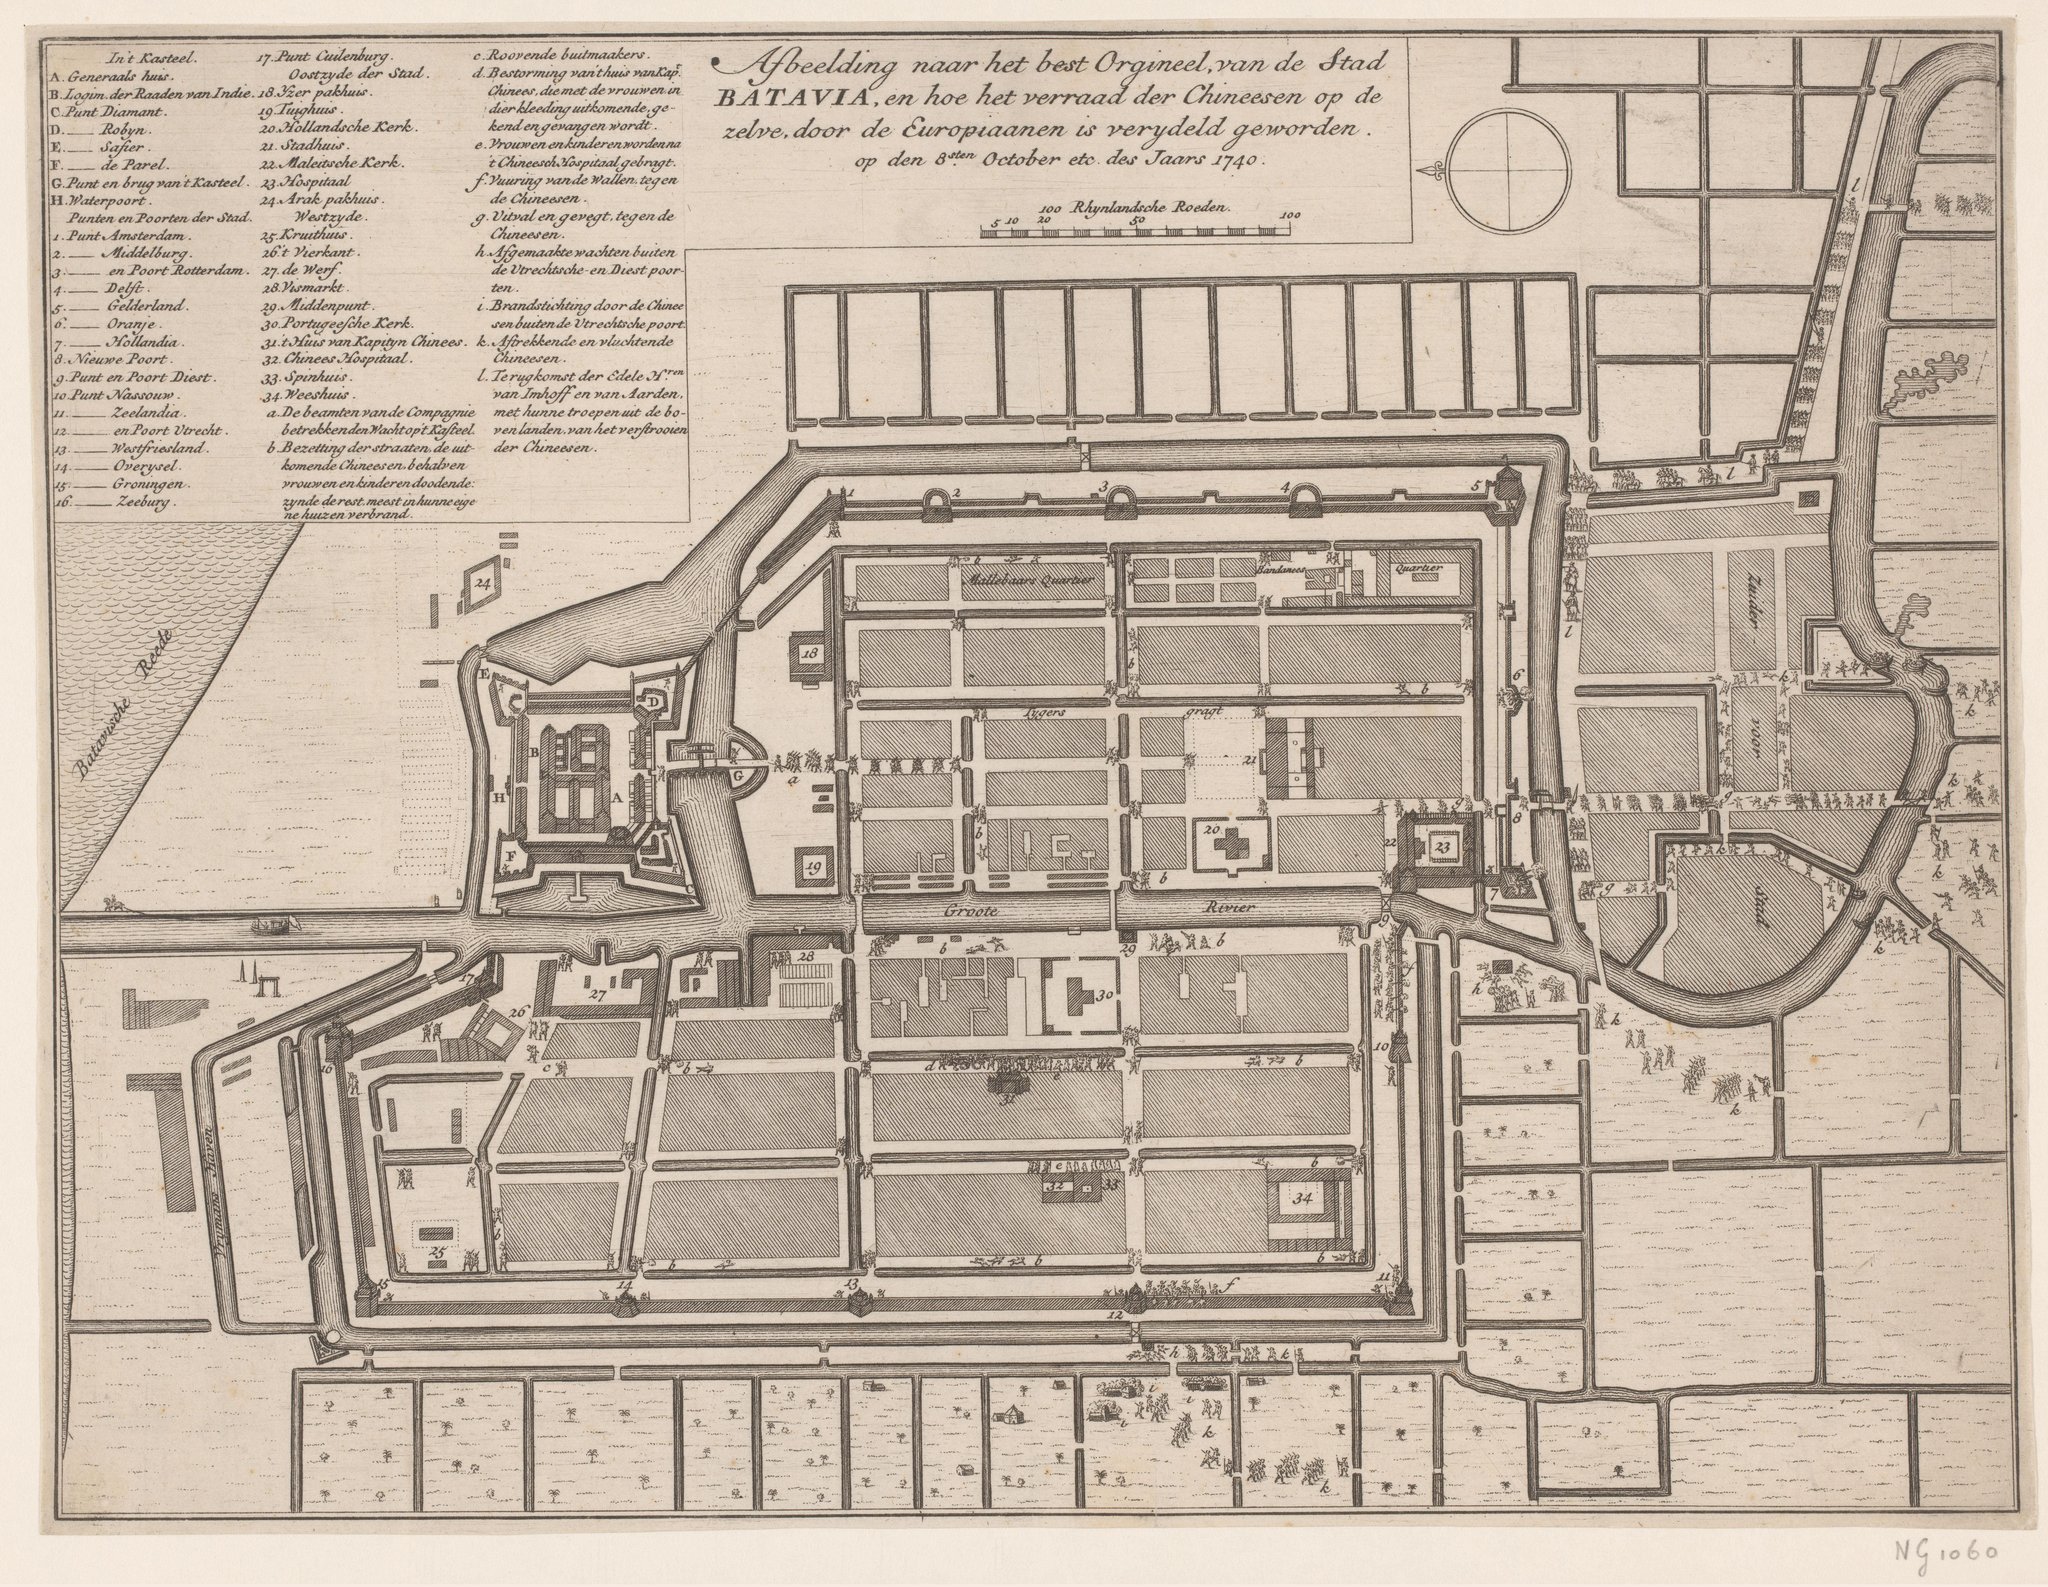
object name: print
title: Afbeelding naar het best Origineel, van de Stad Batavia, en hoe het verraad der Chineesen op de zelve, door de Europiaanen is verydeld geworden, op den 8sten October etc. des Jaars 1740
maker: Anonymous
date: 1740-1741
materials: paper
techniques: etching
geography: northern netherlands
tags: maps of cities, batavia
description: Plattegrond van Batavia ten tijde van de massamoord op de Chinezen door de Nederlanders in de Chinese wijk van Batavia op 9 oktober 1740, na de ontdekking van het vermeende verraad op 8 oktober. Linksboven de legenda.